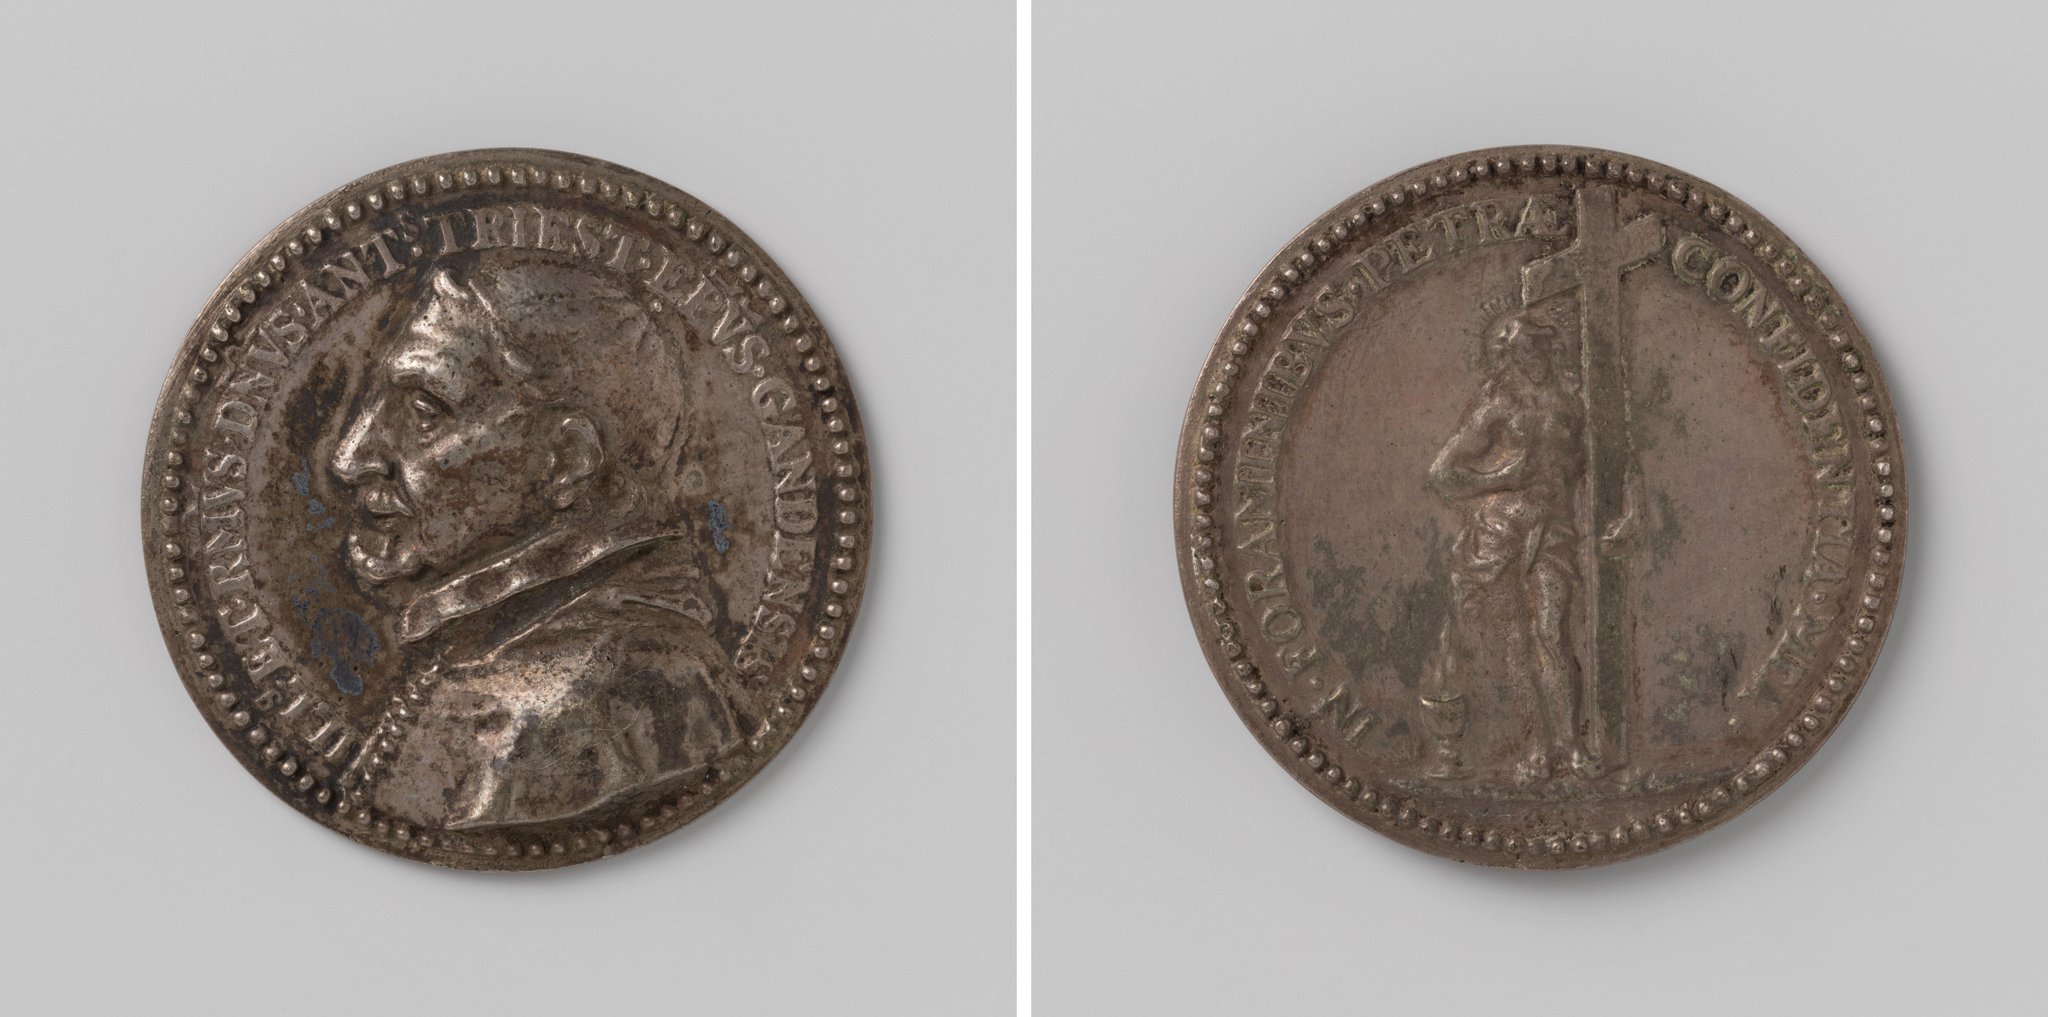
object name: history medal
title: Antonius Triest, bisschop van Gent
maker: adriaan waterloos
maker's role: medailleur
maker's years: 1600-1684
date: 1622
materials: silver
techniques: casting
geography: brussels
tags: ghent, antonius triest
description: Zilveren penning. Voorzijde: borststuk man. Keerzijde: man met lendedoek, aureool en kruis uit wiens lendenen bloed druppelt in een kelk binnen omschrift